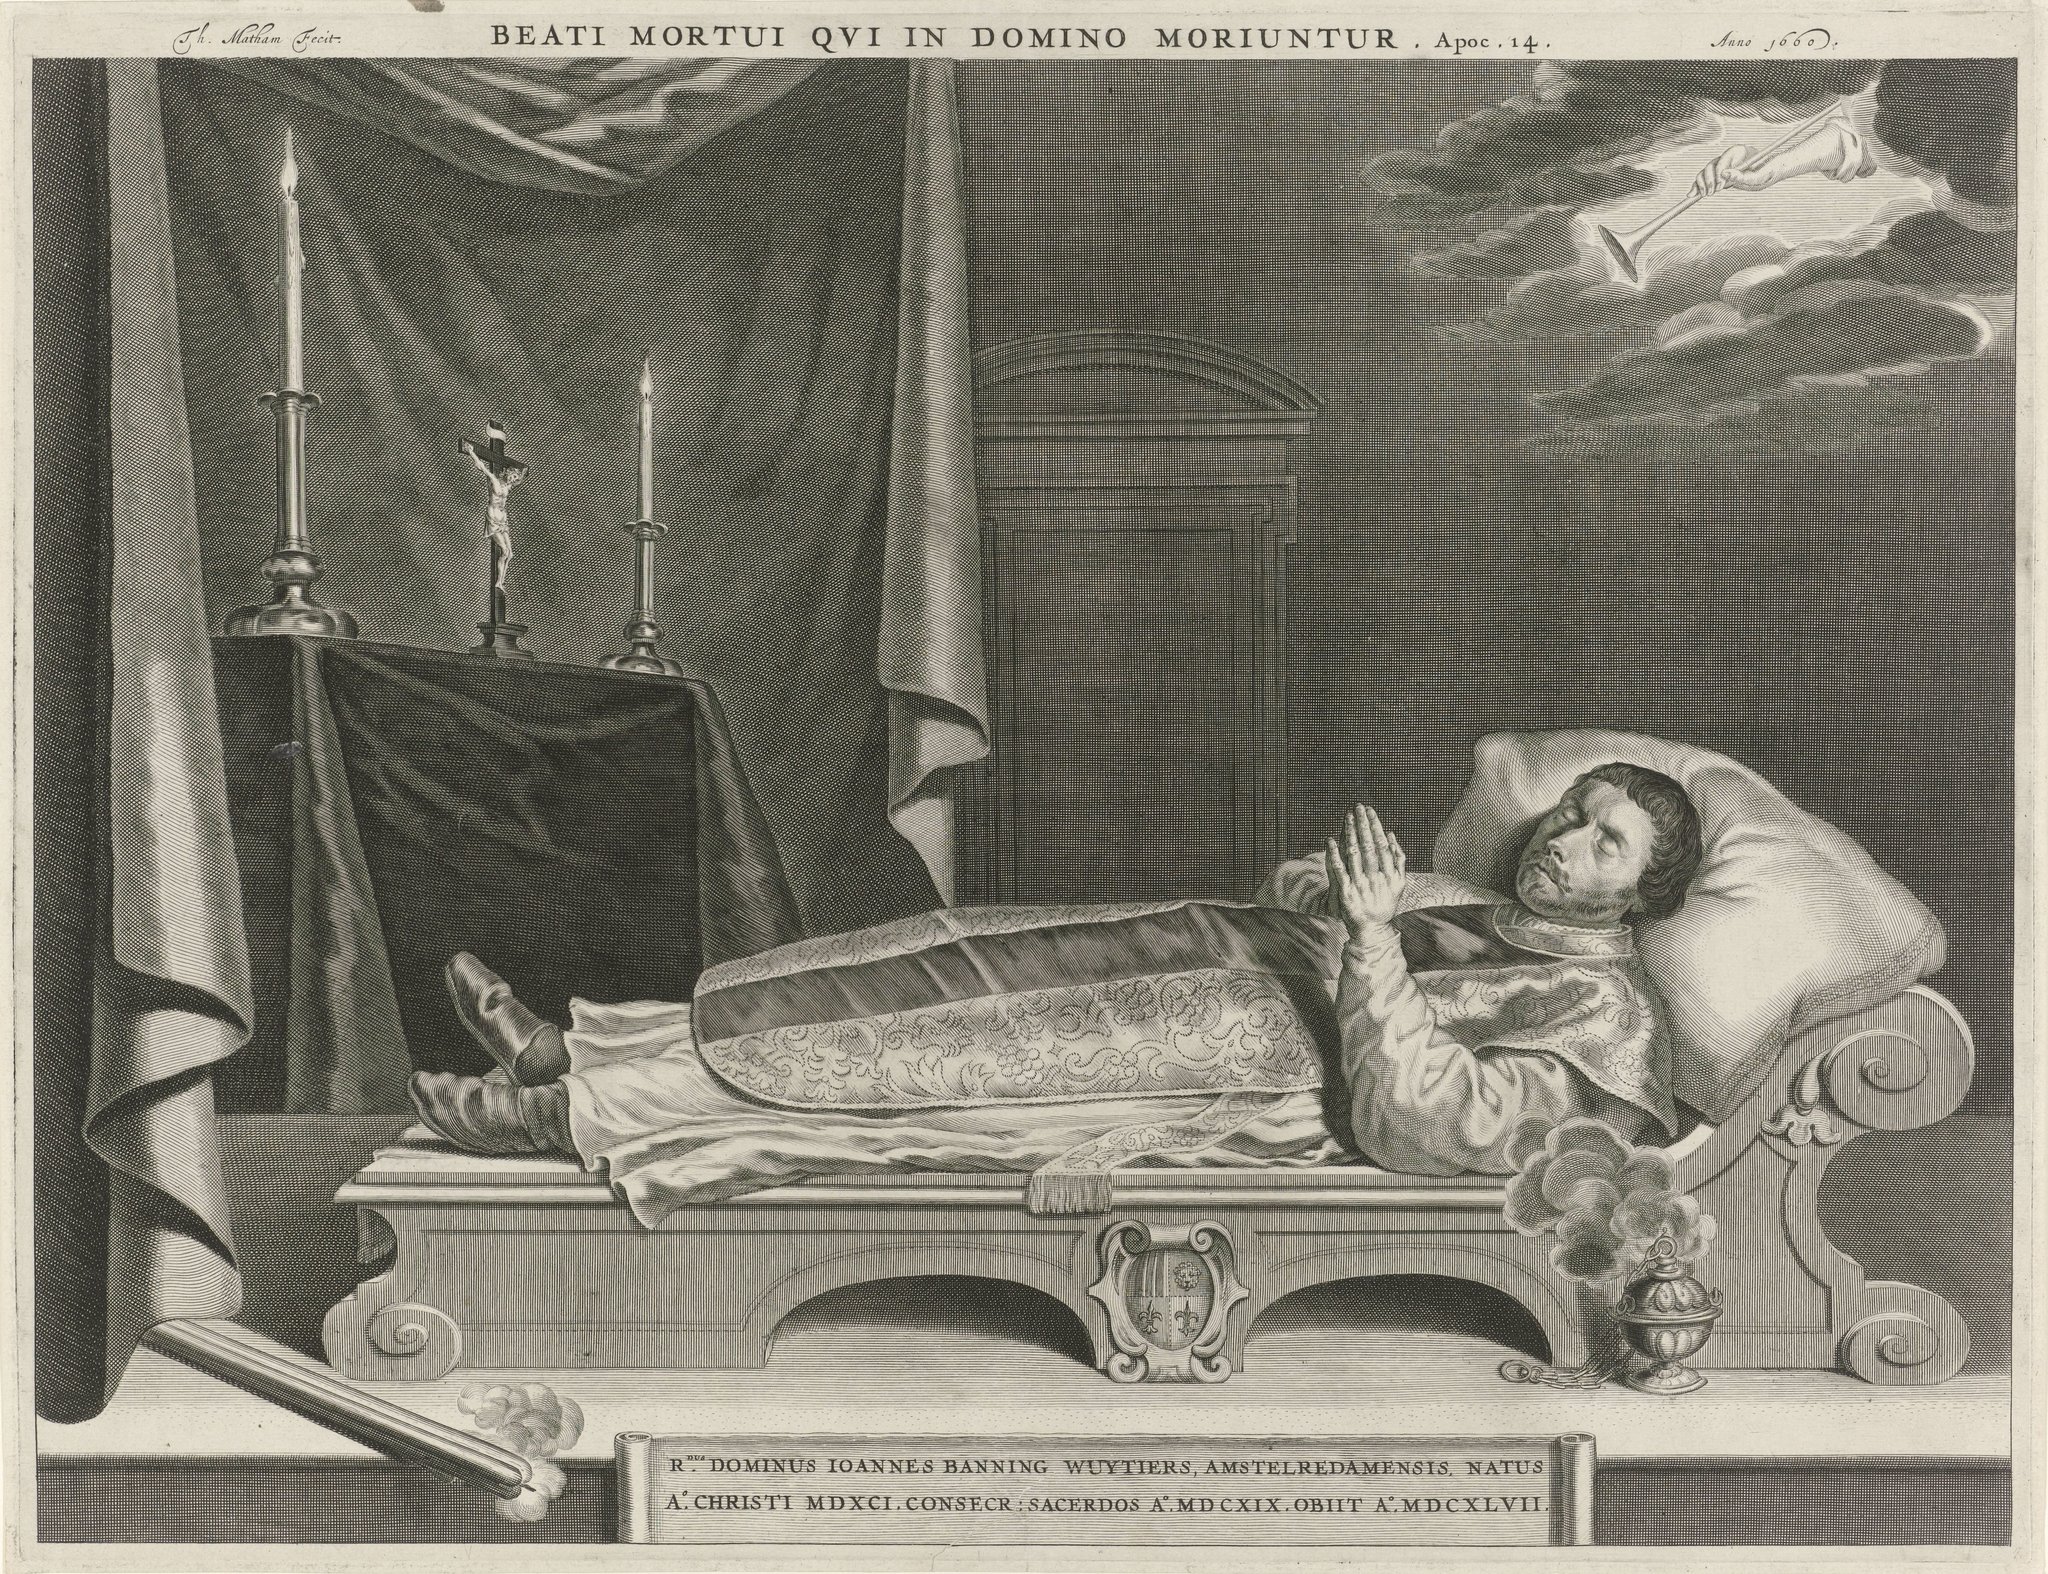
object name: print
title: Praalbed van Joannes Banning Wuytiers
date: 1660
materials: paper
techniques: engraving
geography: northern netherlands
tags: amsterdam, altarcross, crucifix, censer, candle, the corpse placed on a bier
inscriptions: collector's mark: Lugt 240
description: Joannes Banning Wuytiers, opgebaard met gevouwen handen bij een altaar met kaarsen en een crucifix. Links op de voorgrond een gedoofde fakkel en rechtsboven een hand met een bazuin die uit de wolken steekt. naast het doodsbed een wierooksvat.